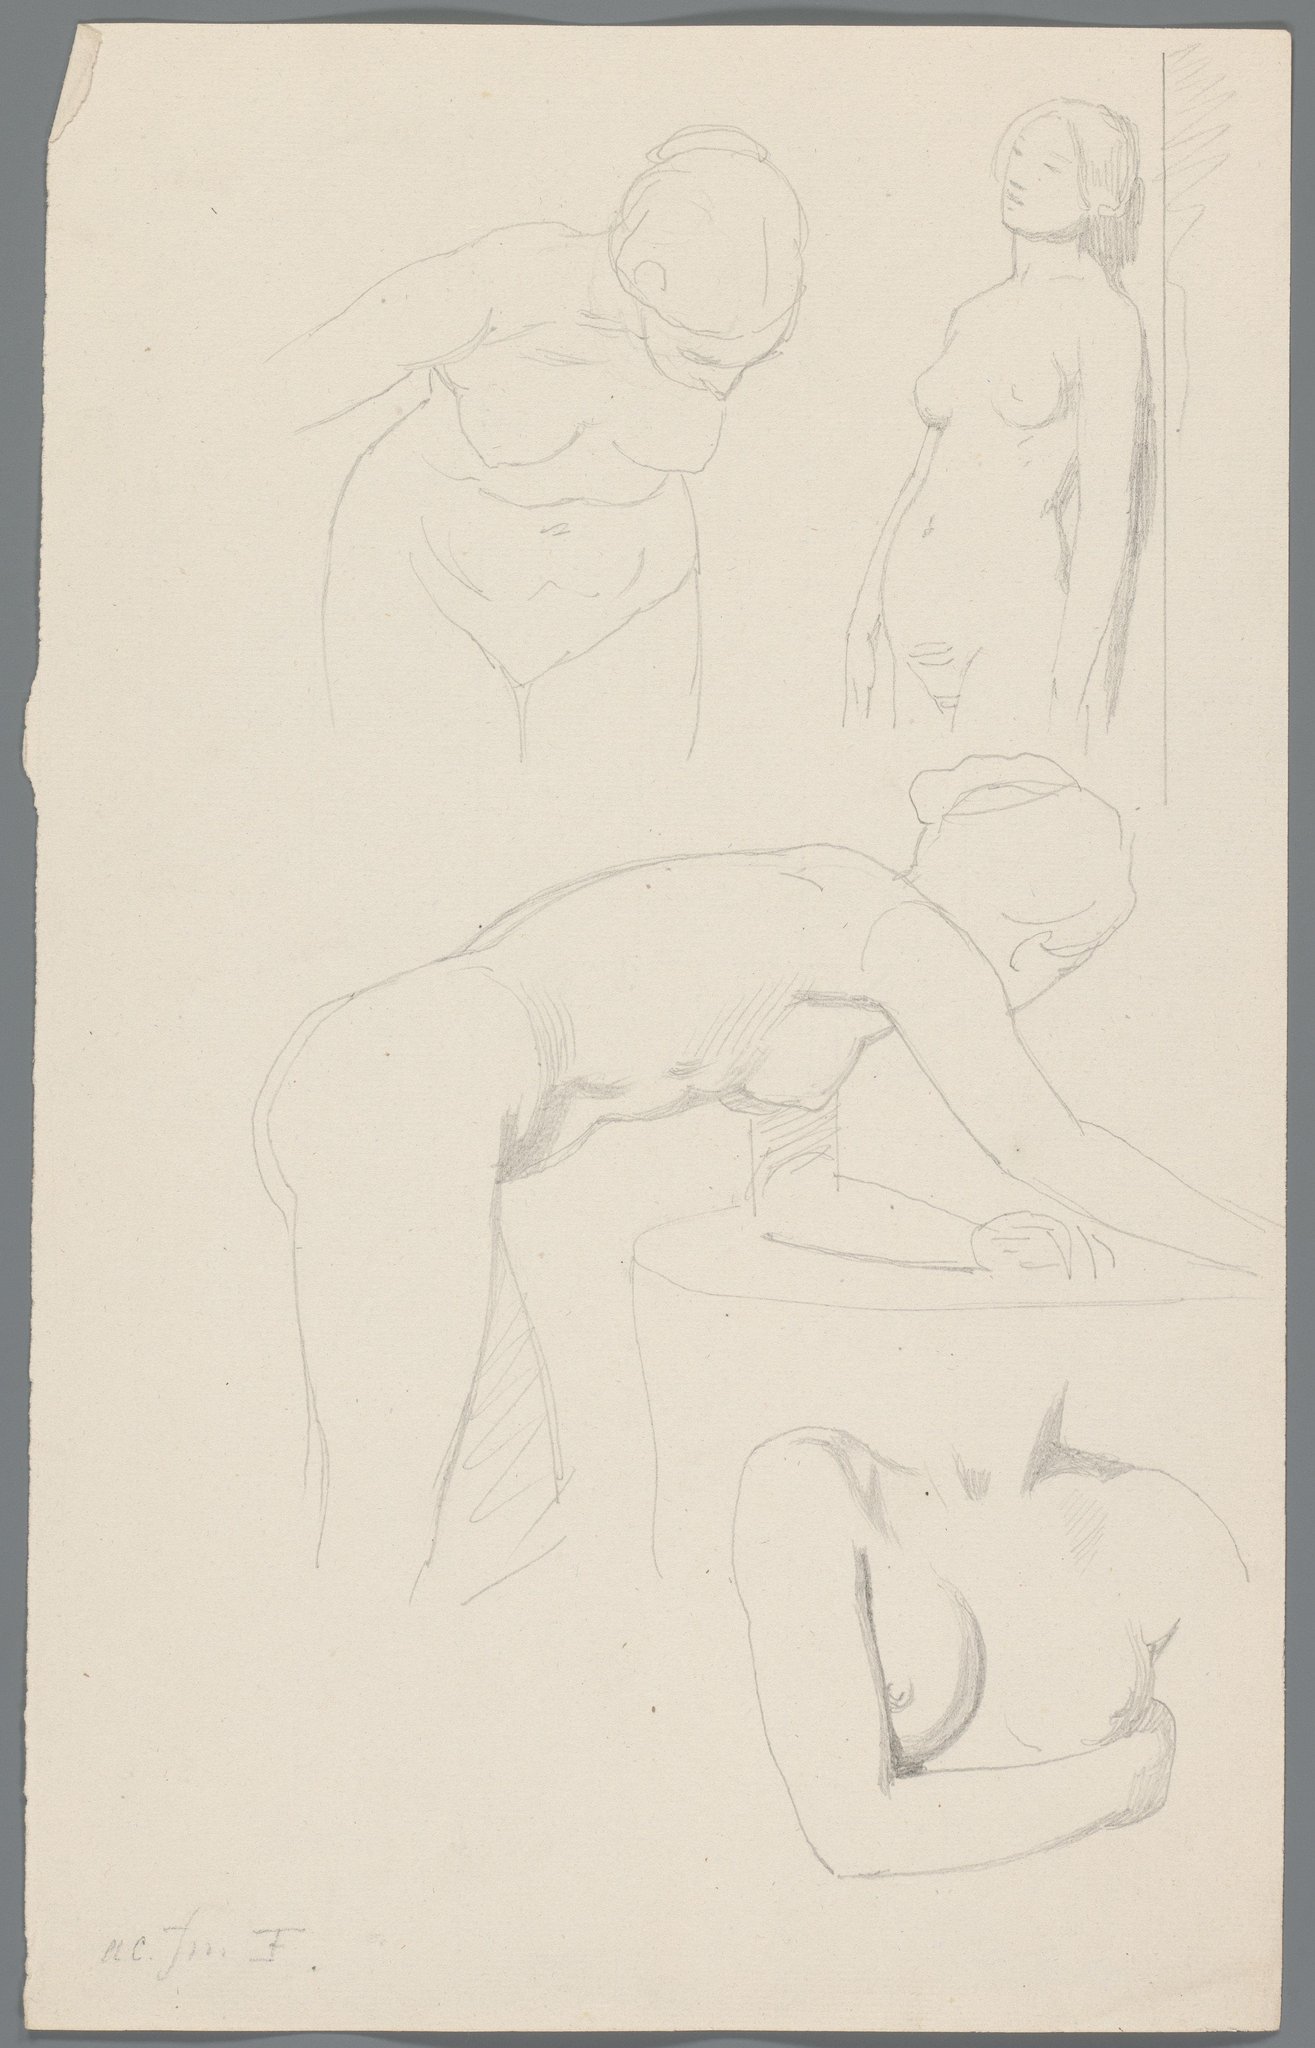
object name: drawing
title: Studies van een naakte vrouw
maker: jacobus everhardus josephus van den berg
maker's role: draughtsman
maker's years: 1802-1861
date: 1856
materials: paper, pencil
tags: the (nude) human figure; 'corpo humano' (ripa) - aa - female human figure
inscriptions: inscription: ‘ac fm EF’